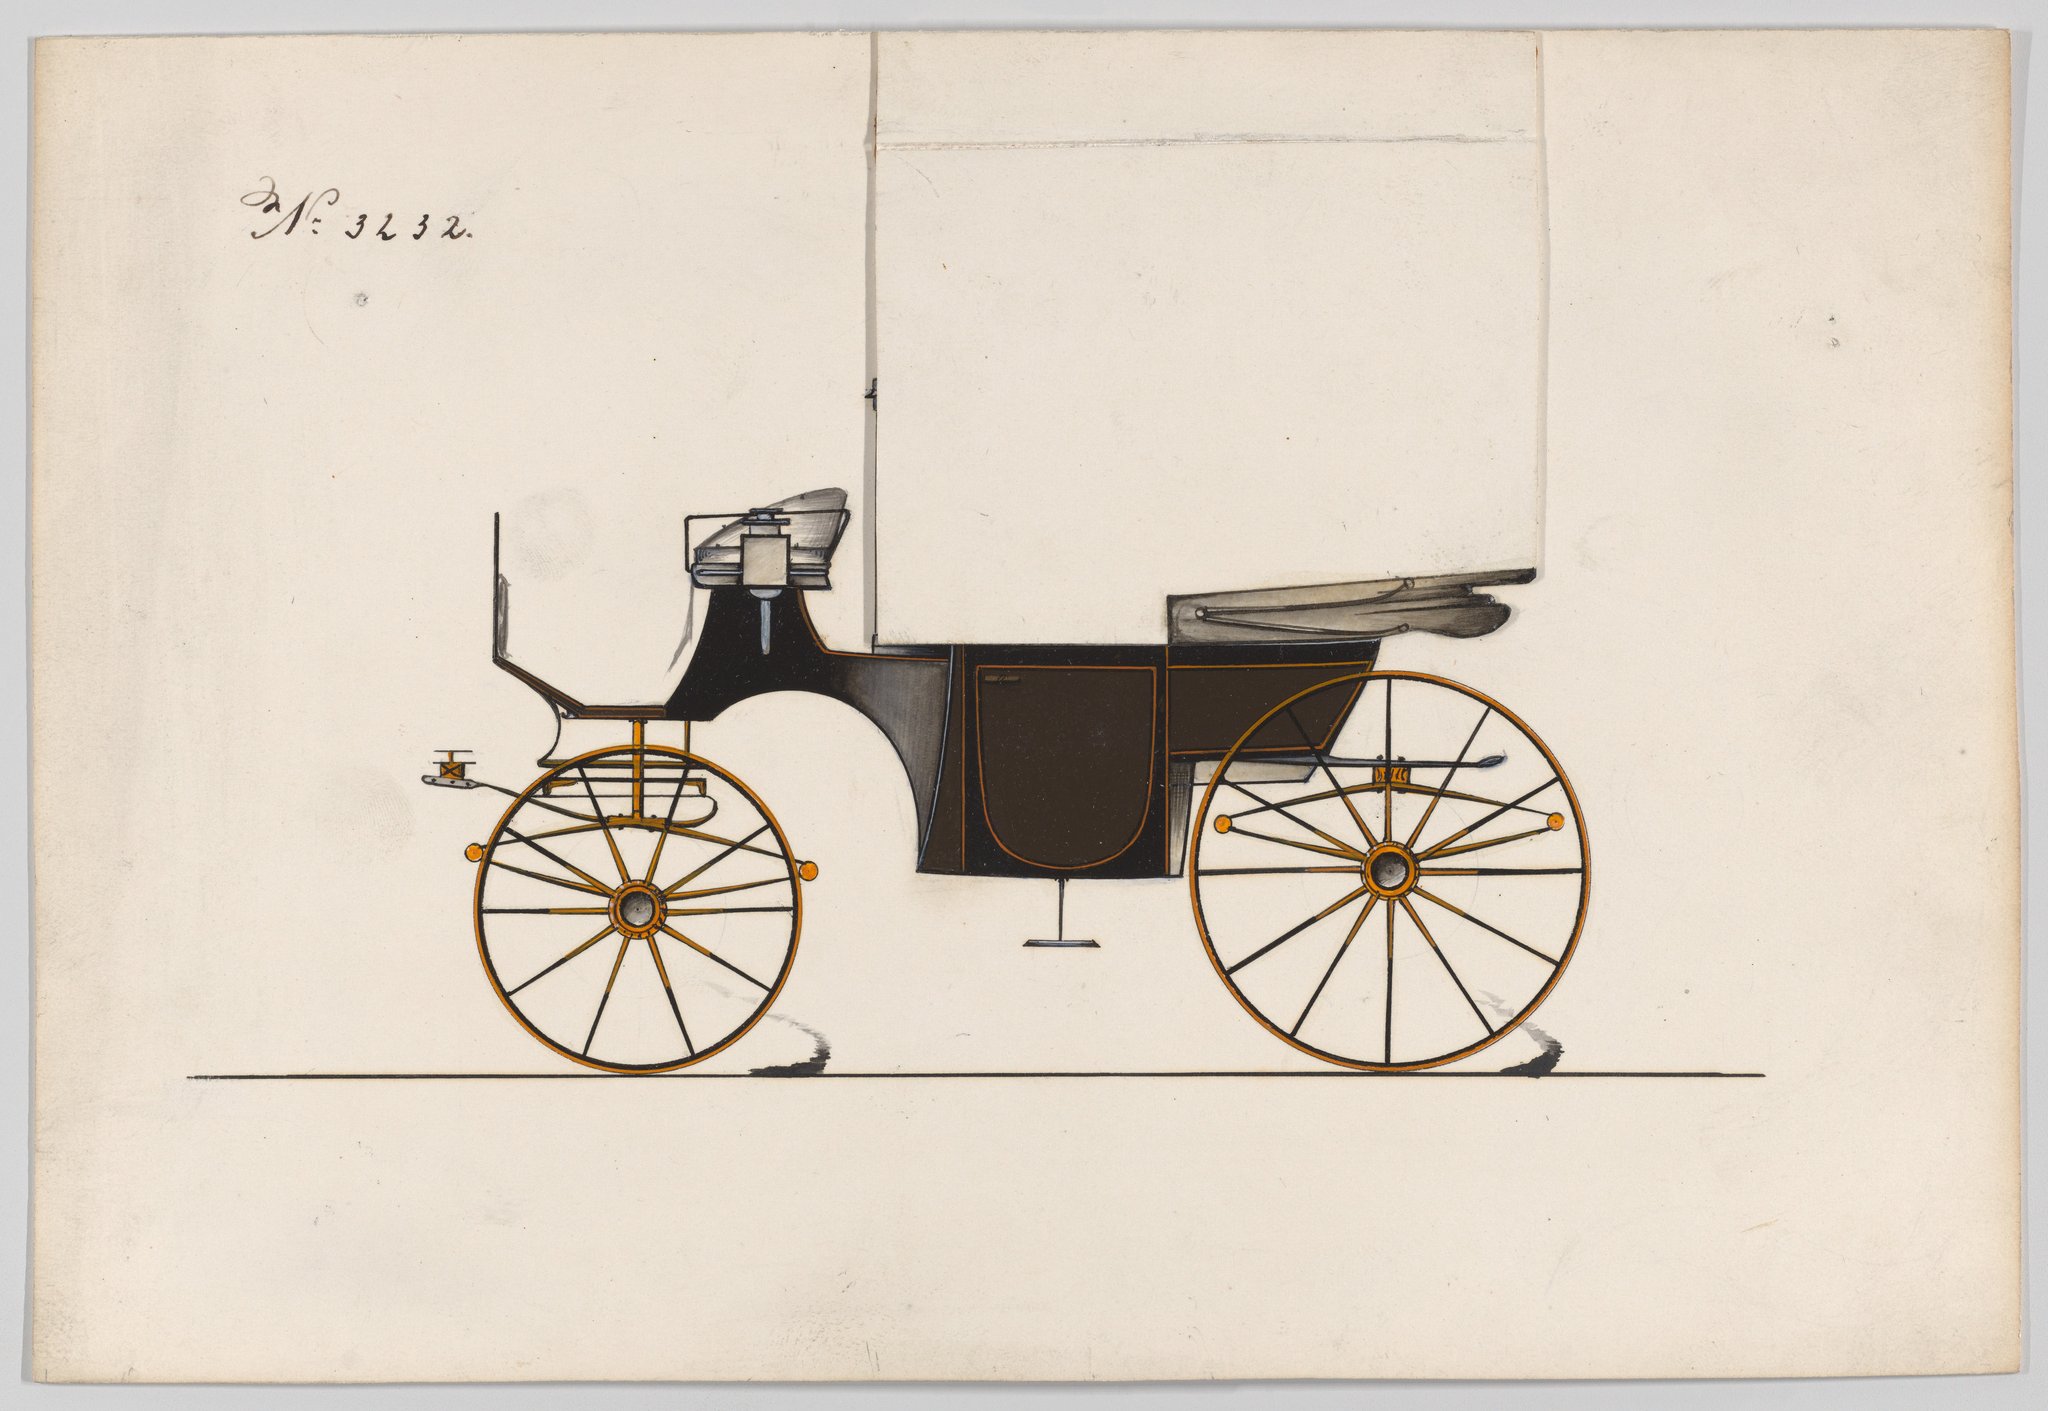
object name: drawing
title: Design for Landaulet, no. 3232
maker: brewster & co.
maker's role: manufacturer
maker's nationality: american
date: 1876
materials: gouache, gum arabic, ink, watercolor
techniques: pen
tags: carriages